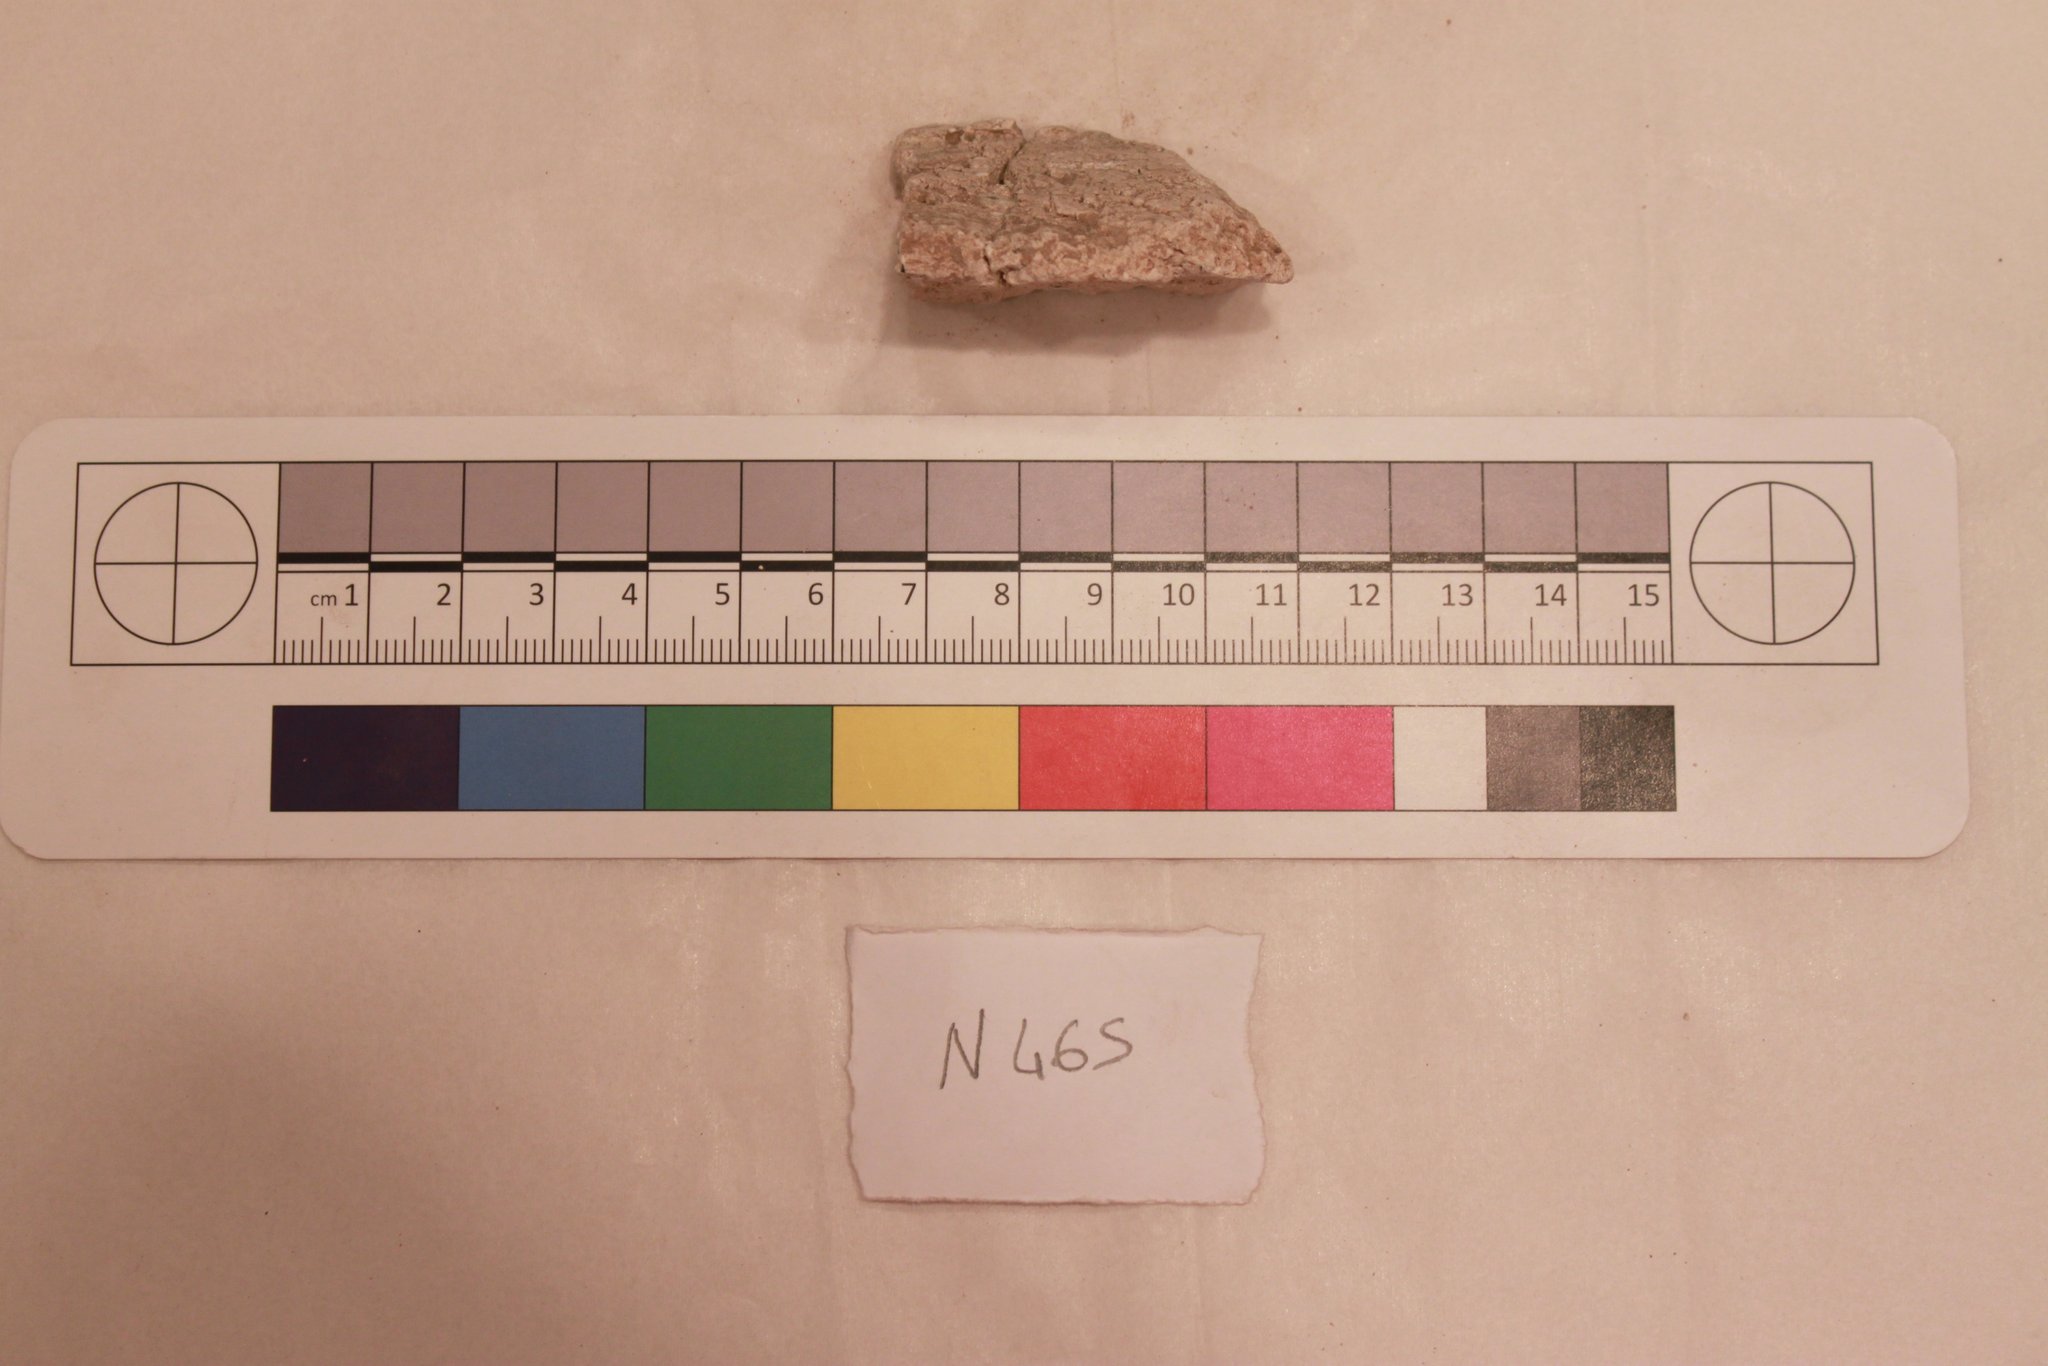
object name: fragment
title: Stucco Fragment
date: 701-1200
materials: plaster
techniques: carving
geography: iran